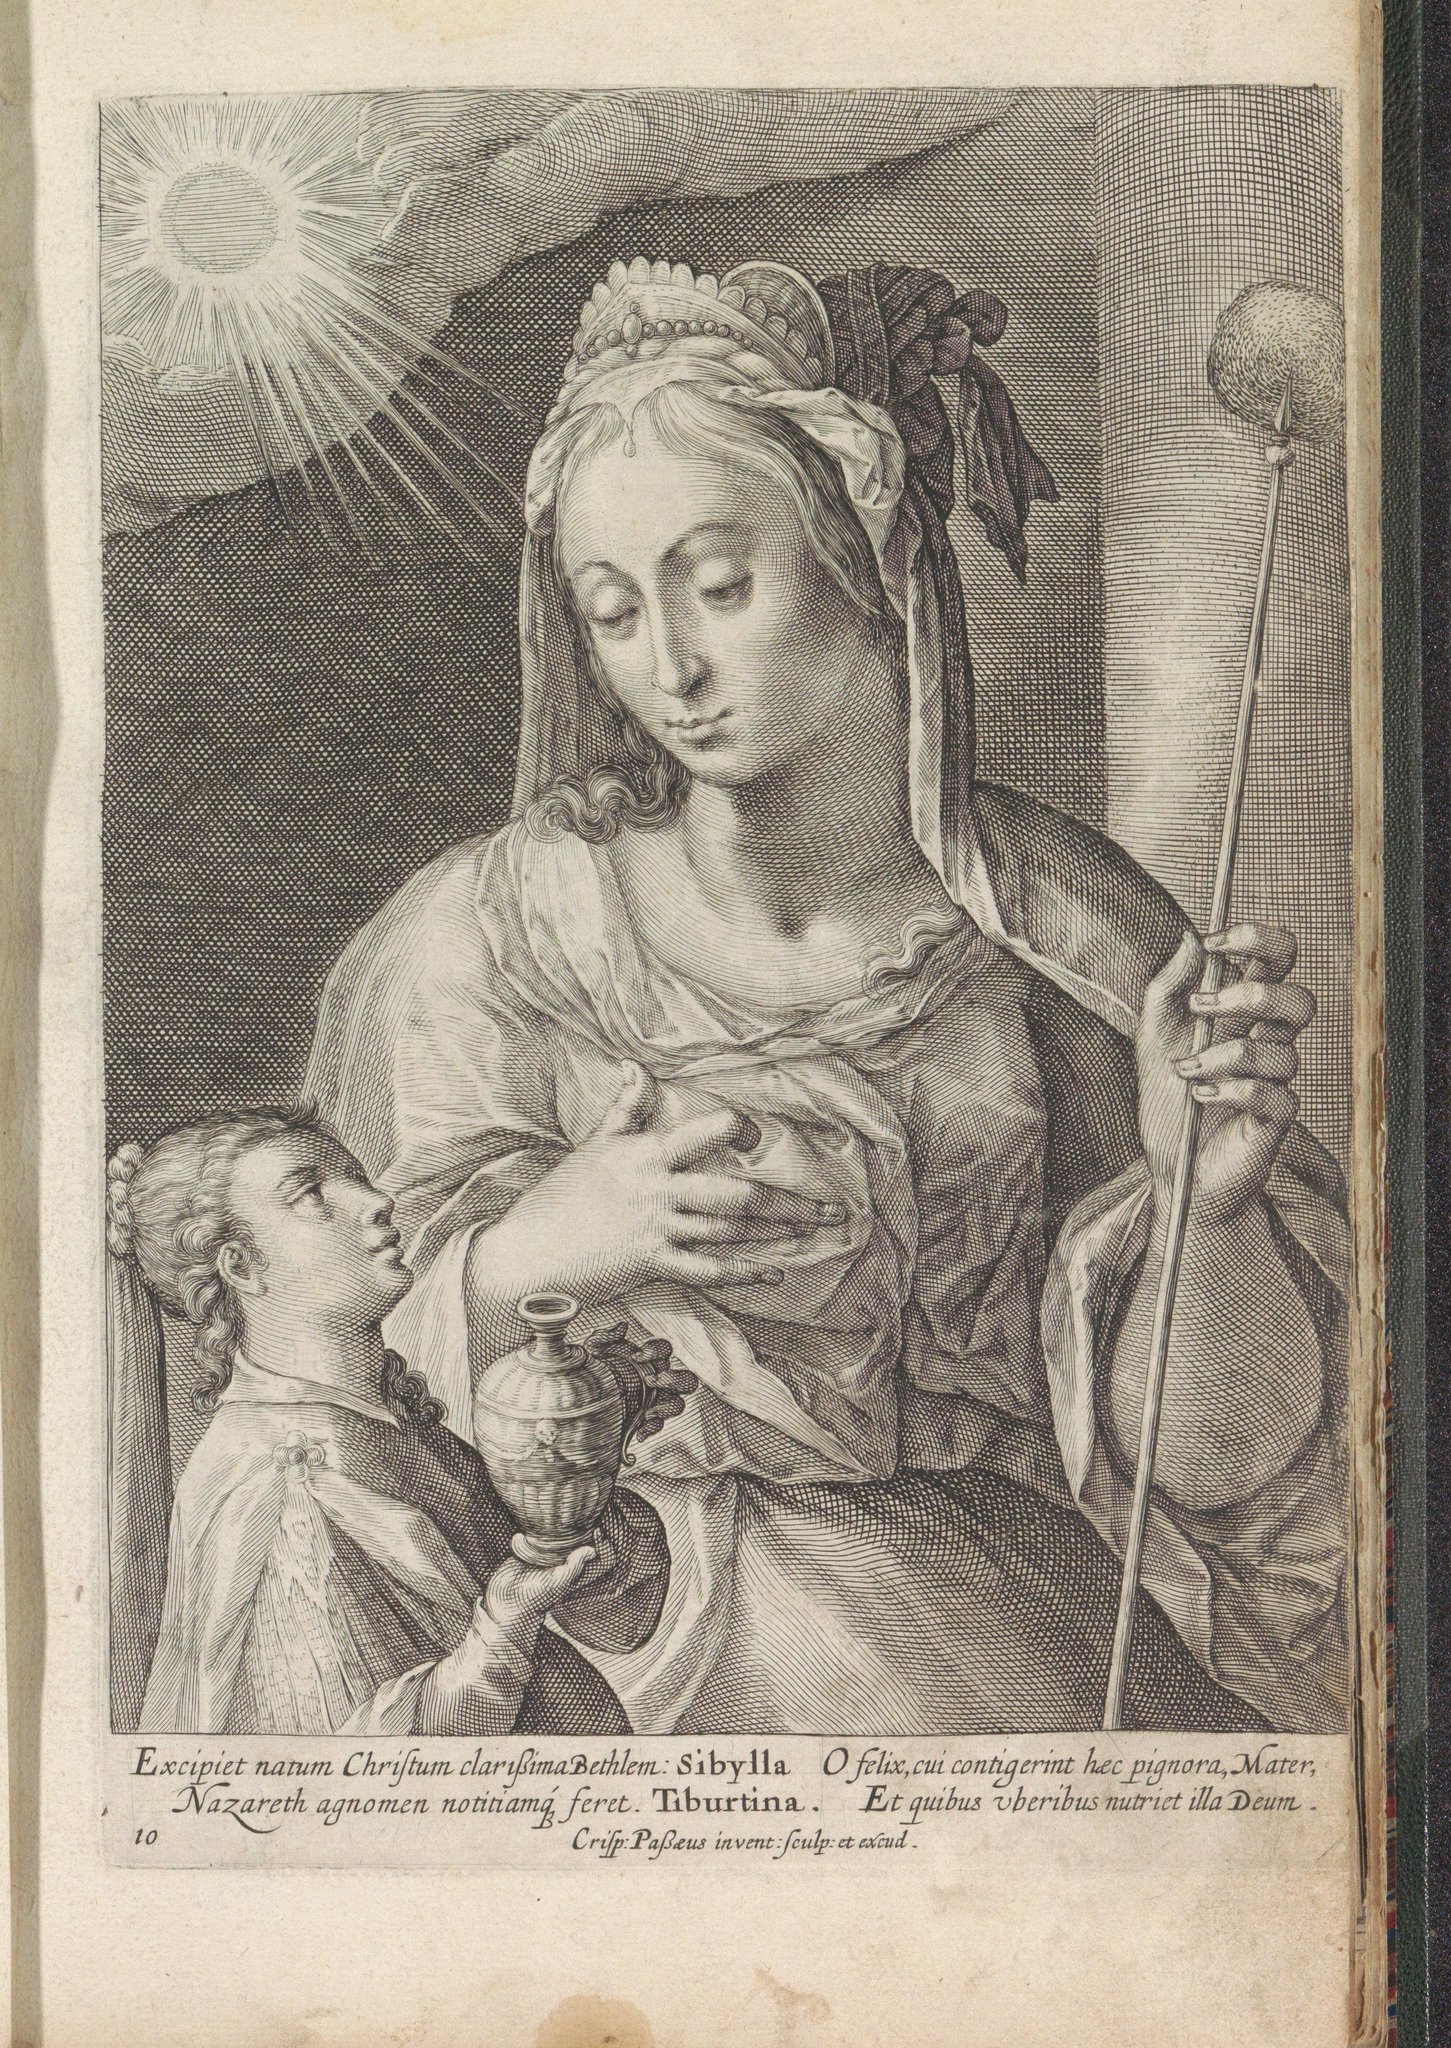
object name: album leaf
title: Tiburtijnse Sibille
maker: crispijn van de passe (i)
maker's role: draughtsman, print maker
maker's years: 1564-1637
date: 1615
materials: paper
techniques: engraving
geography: utrecht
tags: sibyls (with name)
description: De Tiburtijnse Sibille zit met een speer in de hand. Voor haar staat een jong meisje dat haar een kruik aanbiedt. Onder de voorstelling een onderschrift in het Latijn. Deze prent maakt deel uit van een album.